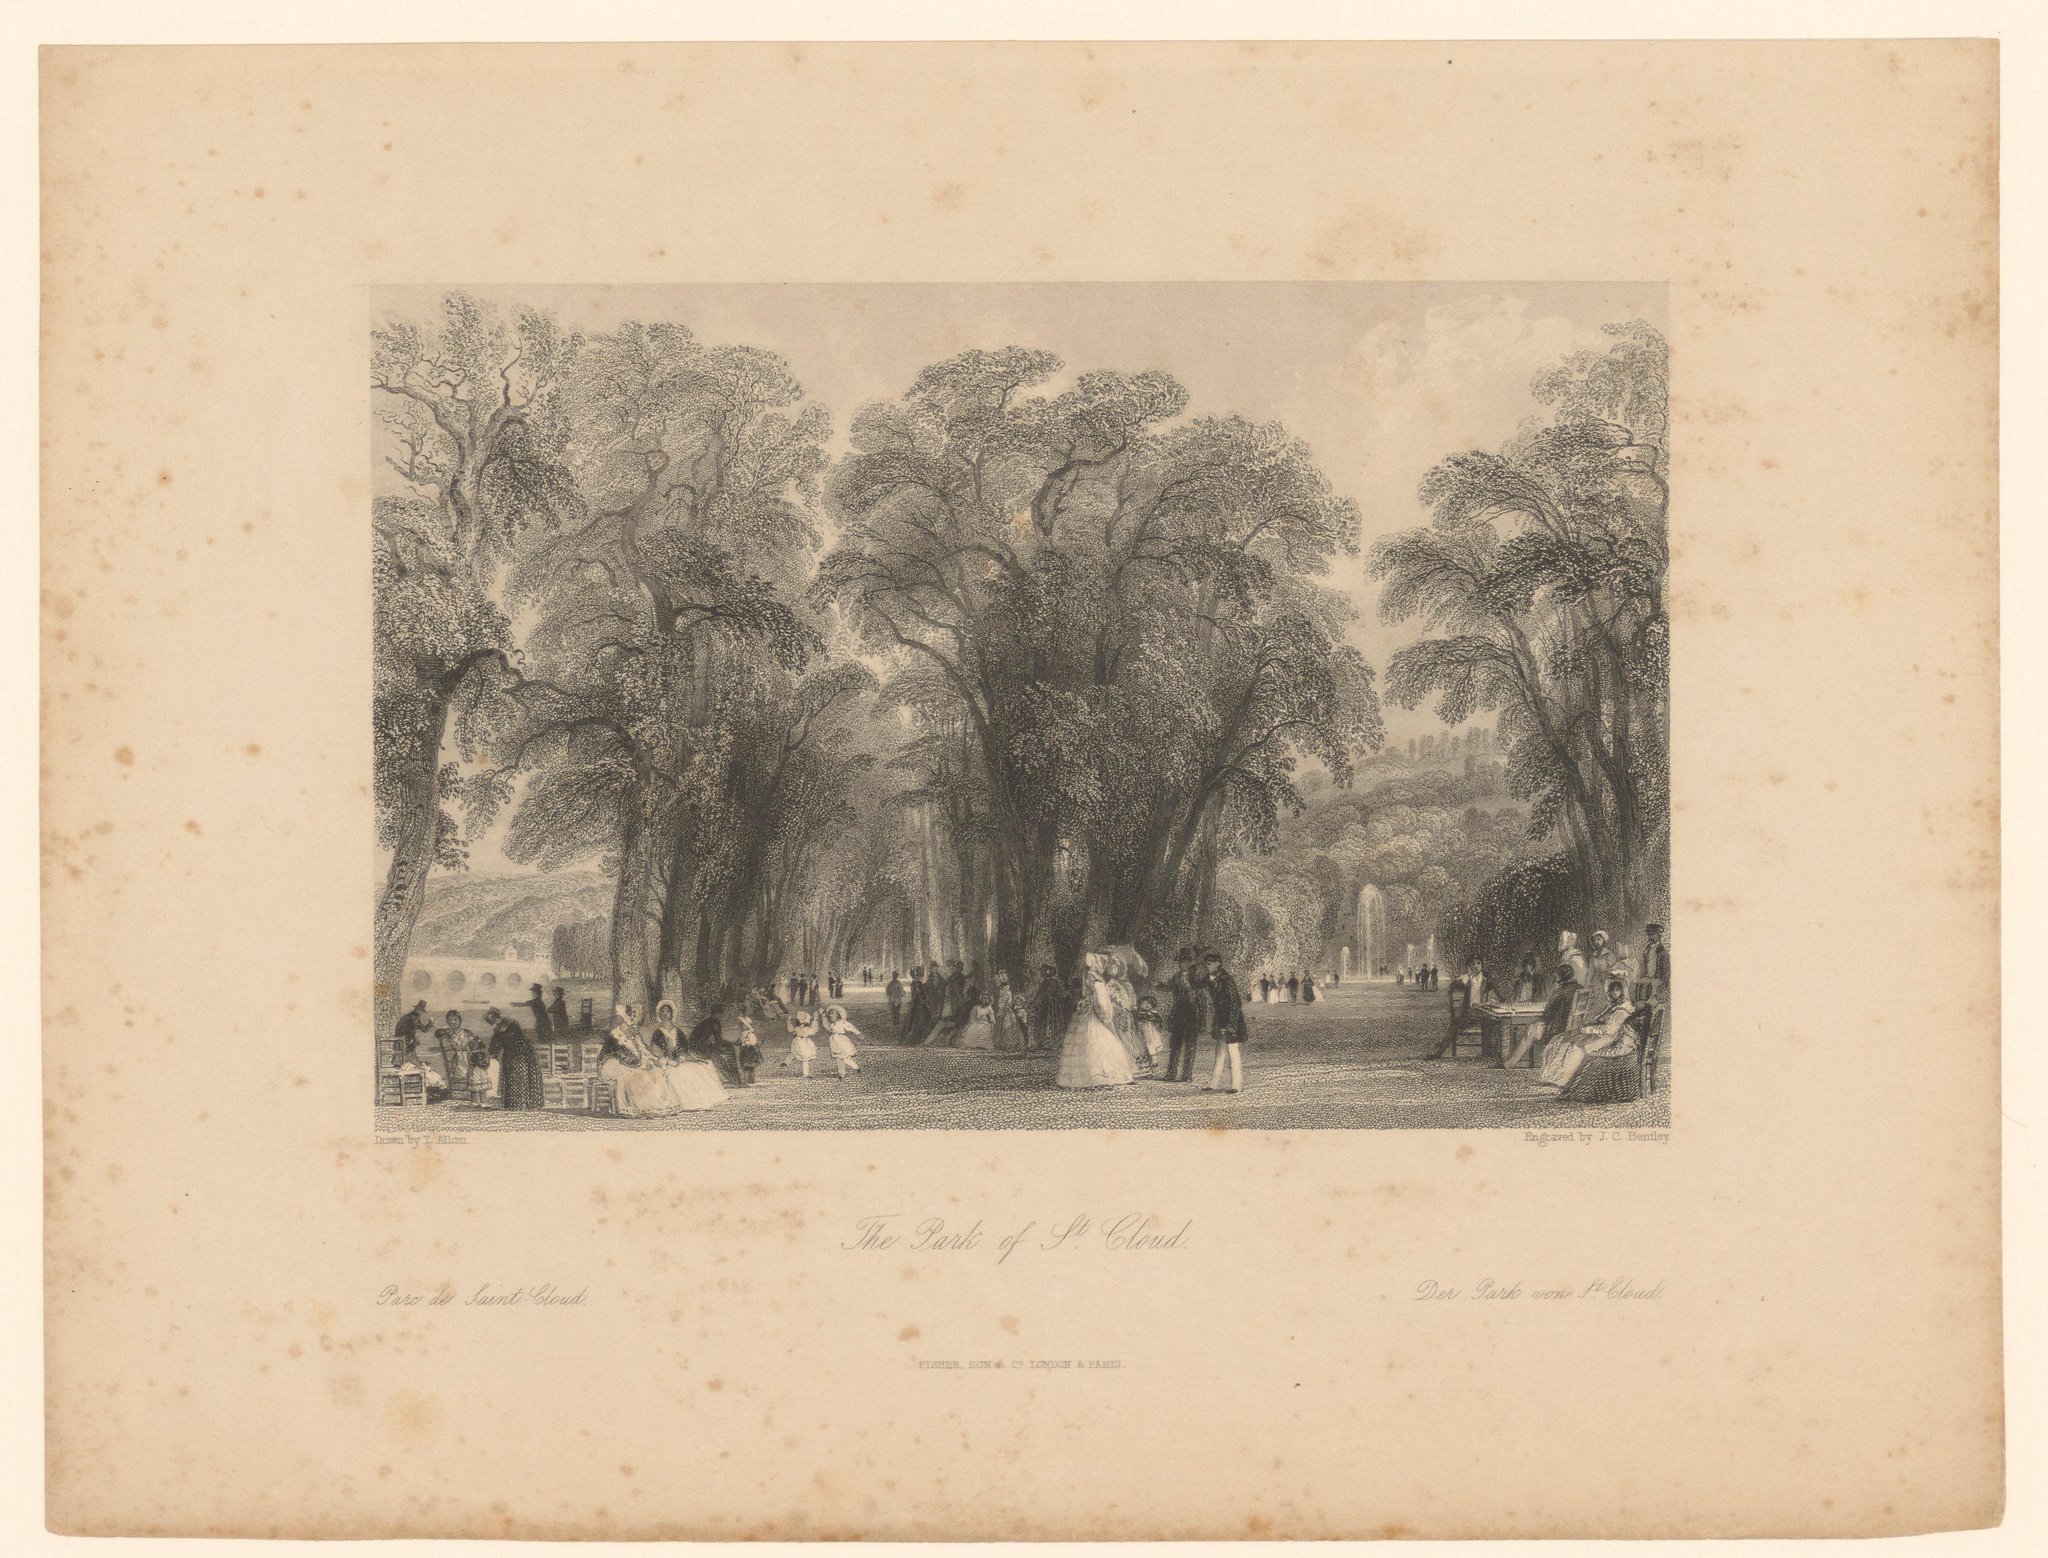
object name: print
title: The Park of St. Cloud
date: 1828-1847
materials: paper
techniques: engraving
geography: paris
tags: park, walking, hiking (recreation)